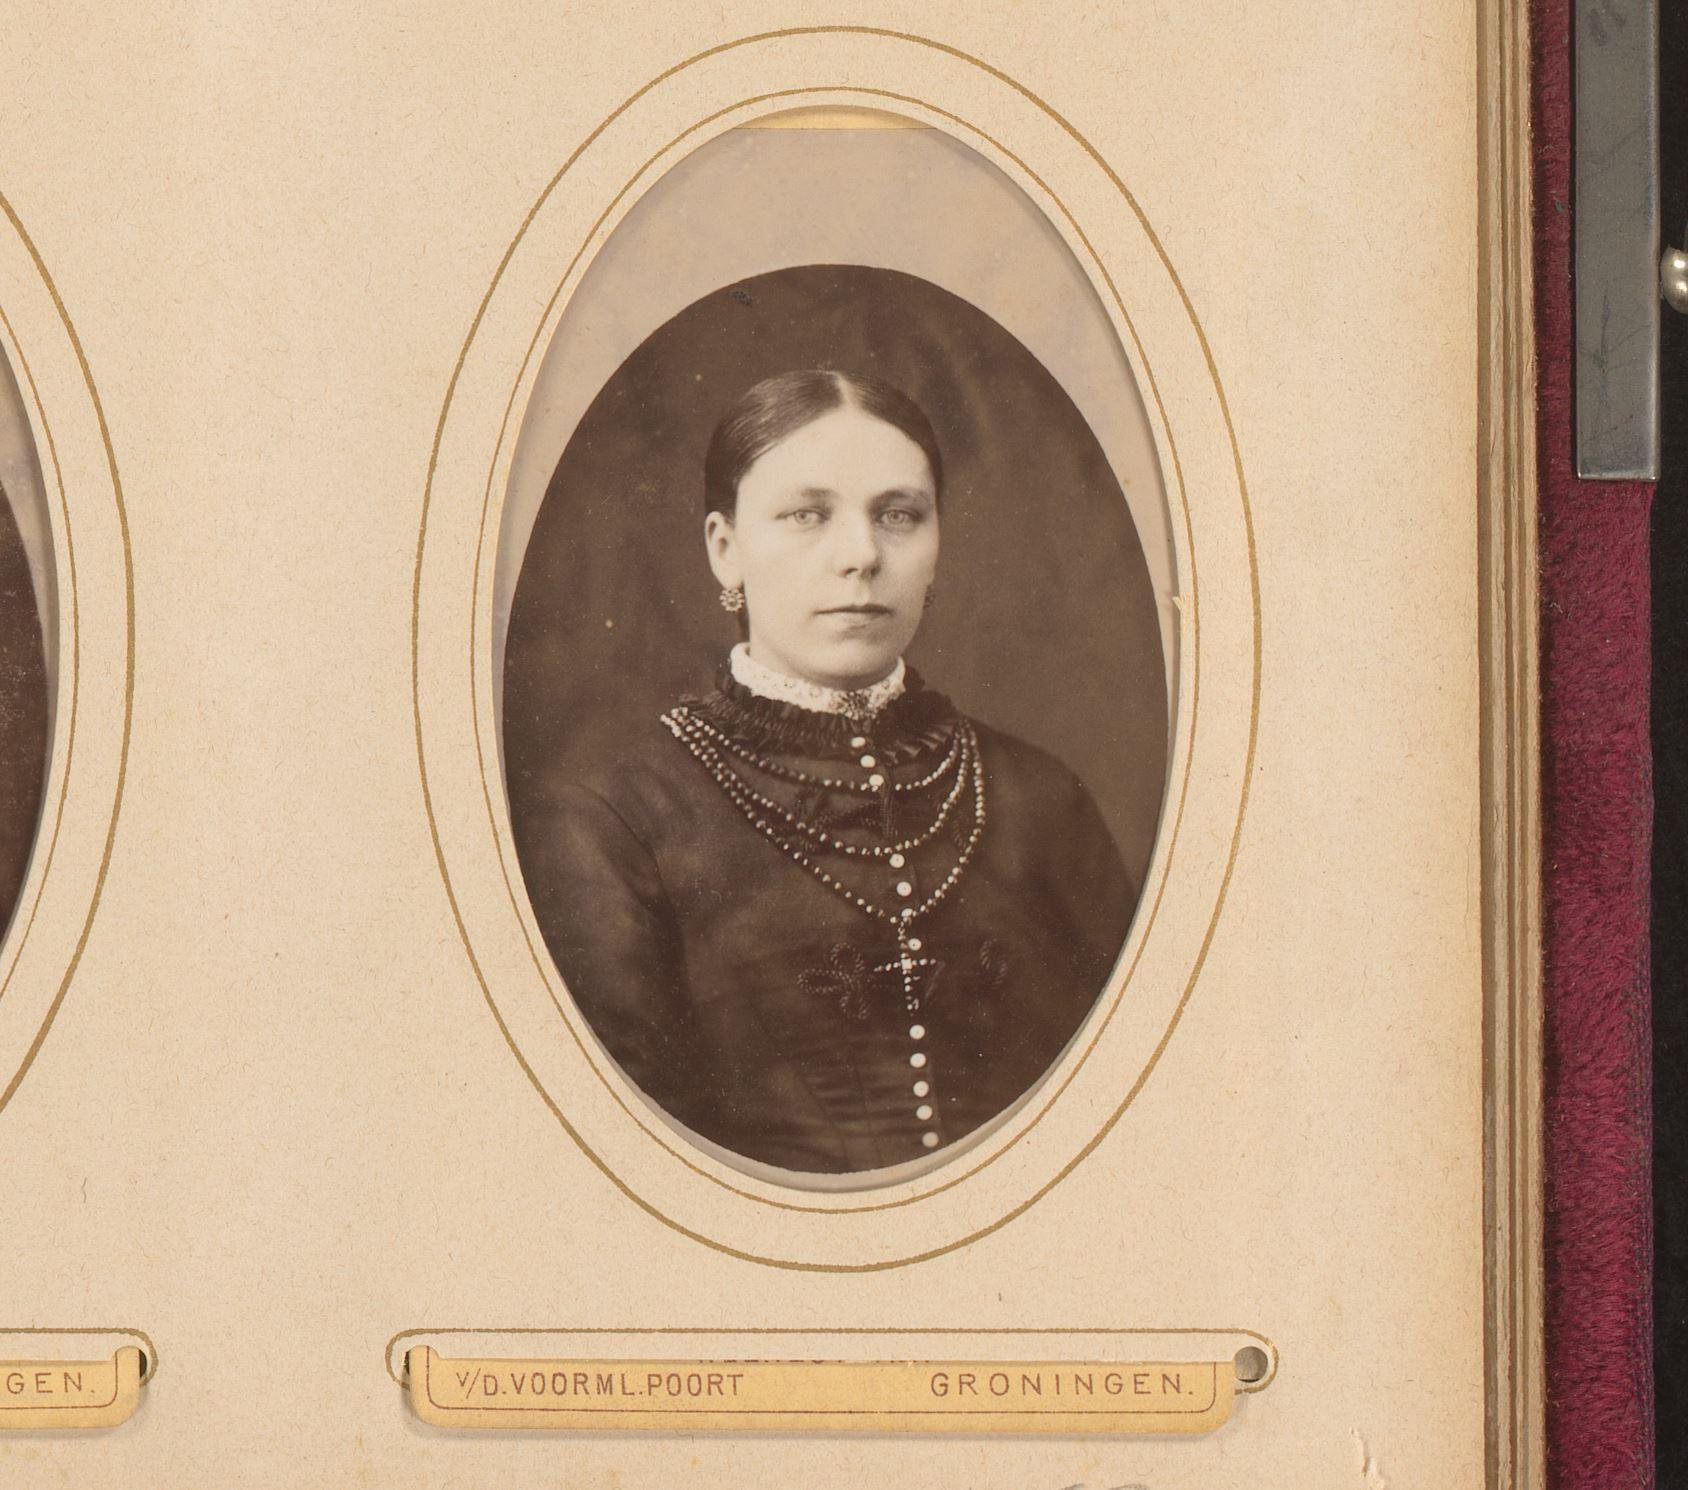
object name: album leaf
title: Portret van een vrouw met ketting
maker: benjamin sanders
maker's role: fotograaf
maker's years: 1841-1889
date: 1856-1889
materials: cardboard, photographic support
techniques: albumen print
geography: groningen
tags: historical persons - bb - woman, necklace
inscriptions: inscription: ‘Photographisch Atelier/ Benjamin Sanders/ Groningen/ Heerestraat v/d voorml. poort R.514’